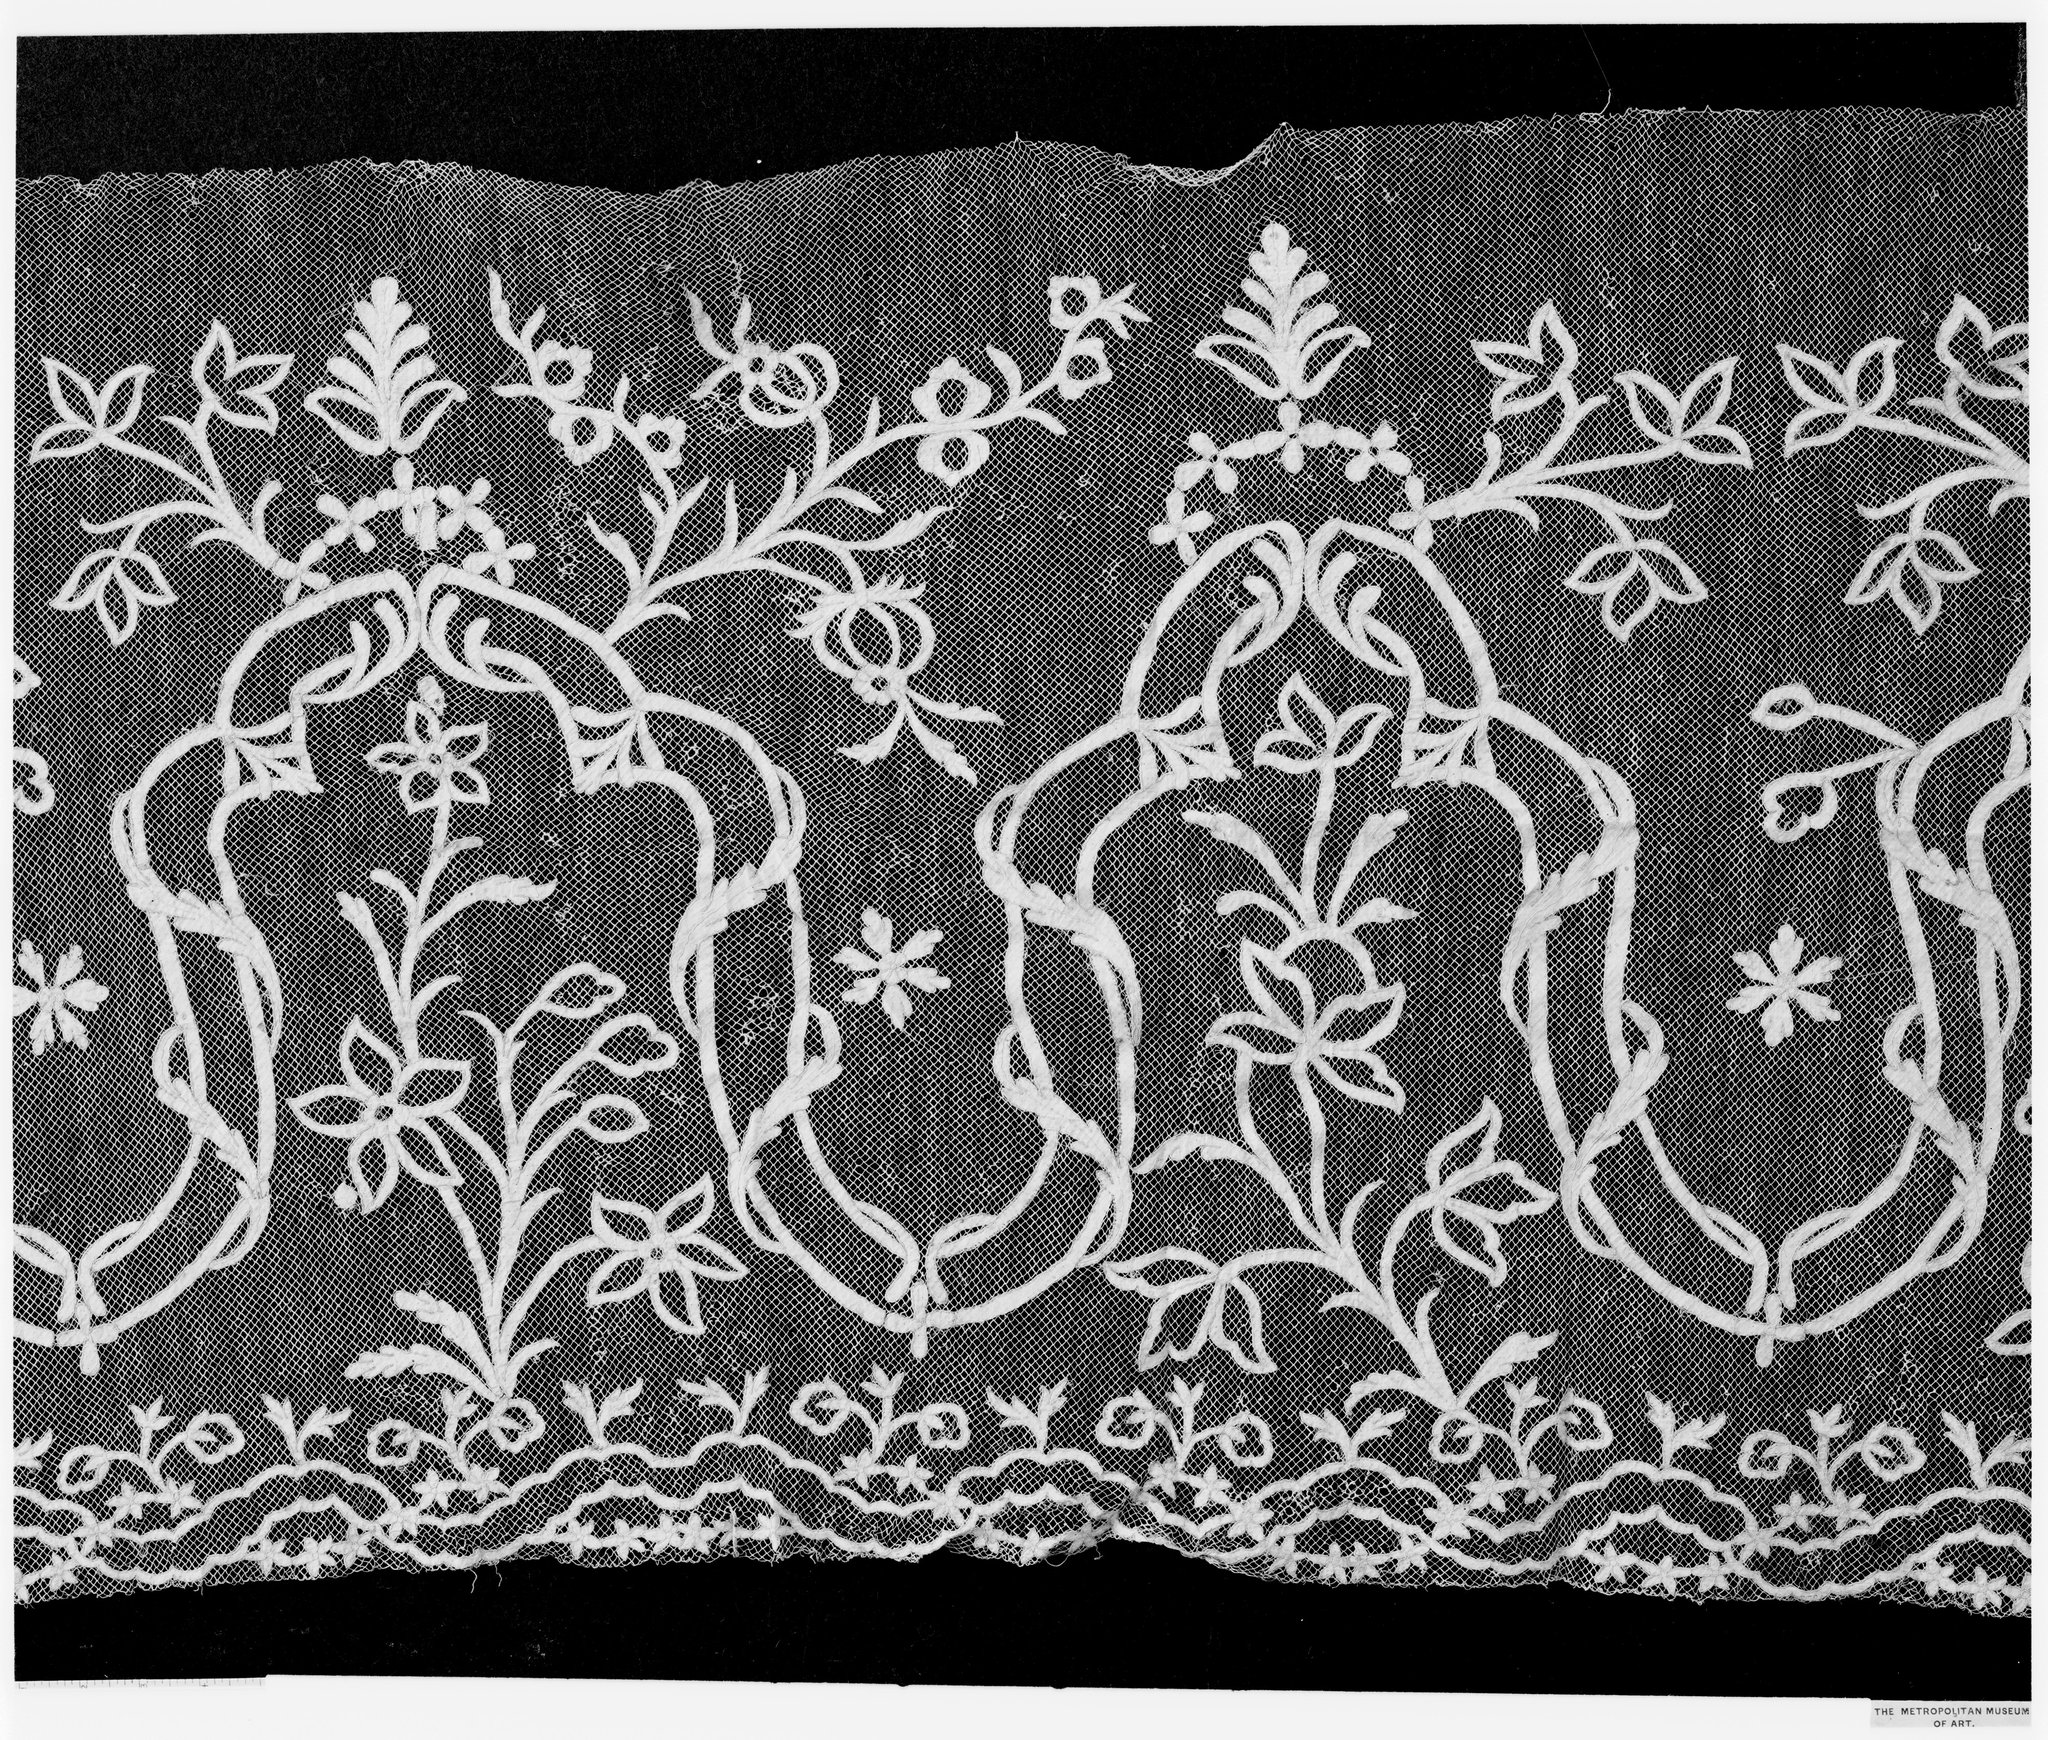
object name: border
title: Border (Bas de rochet)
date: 1750